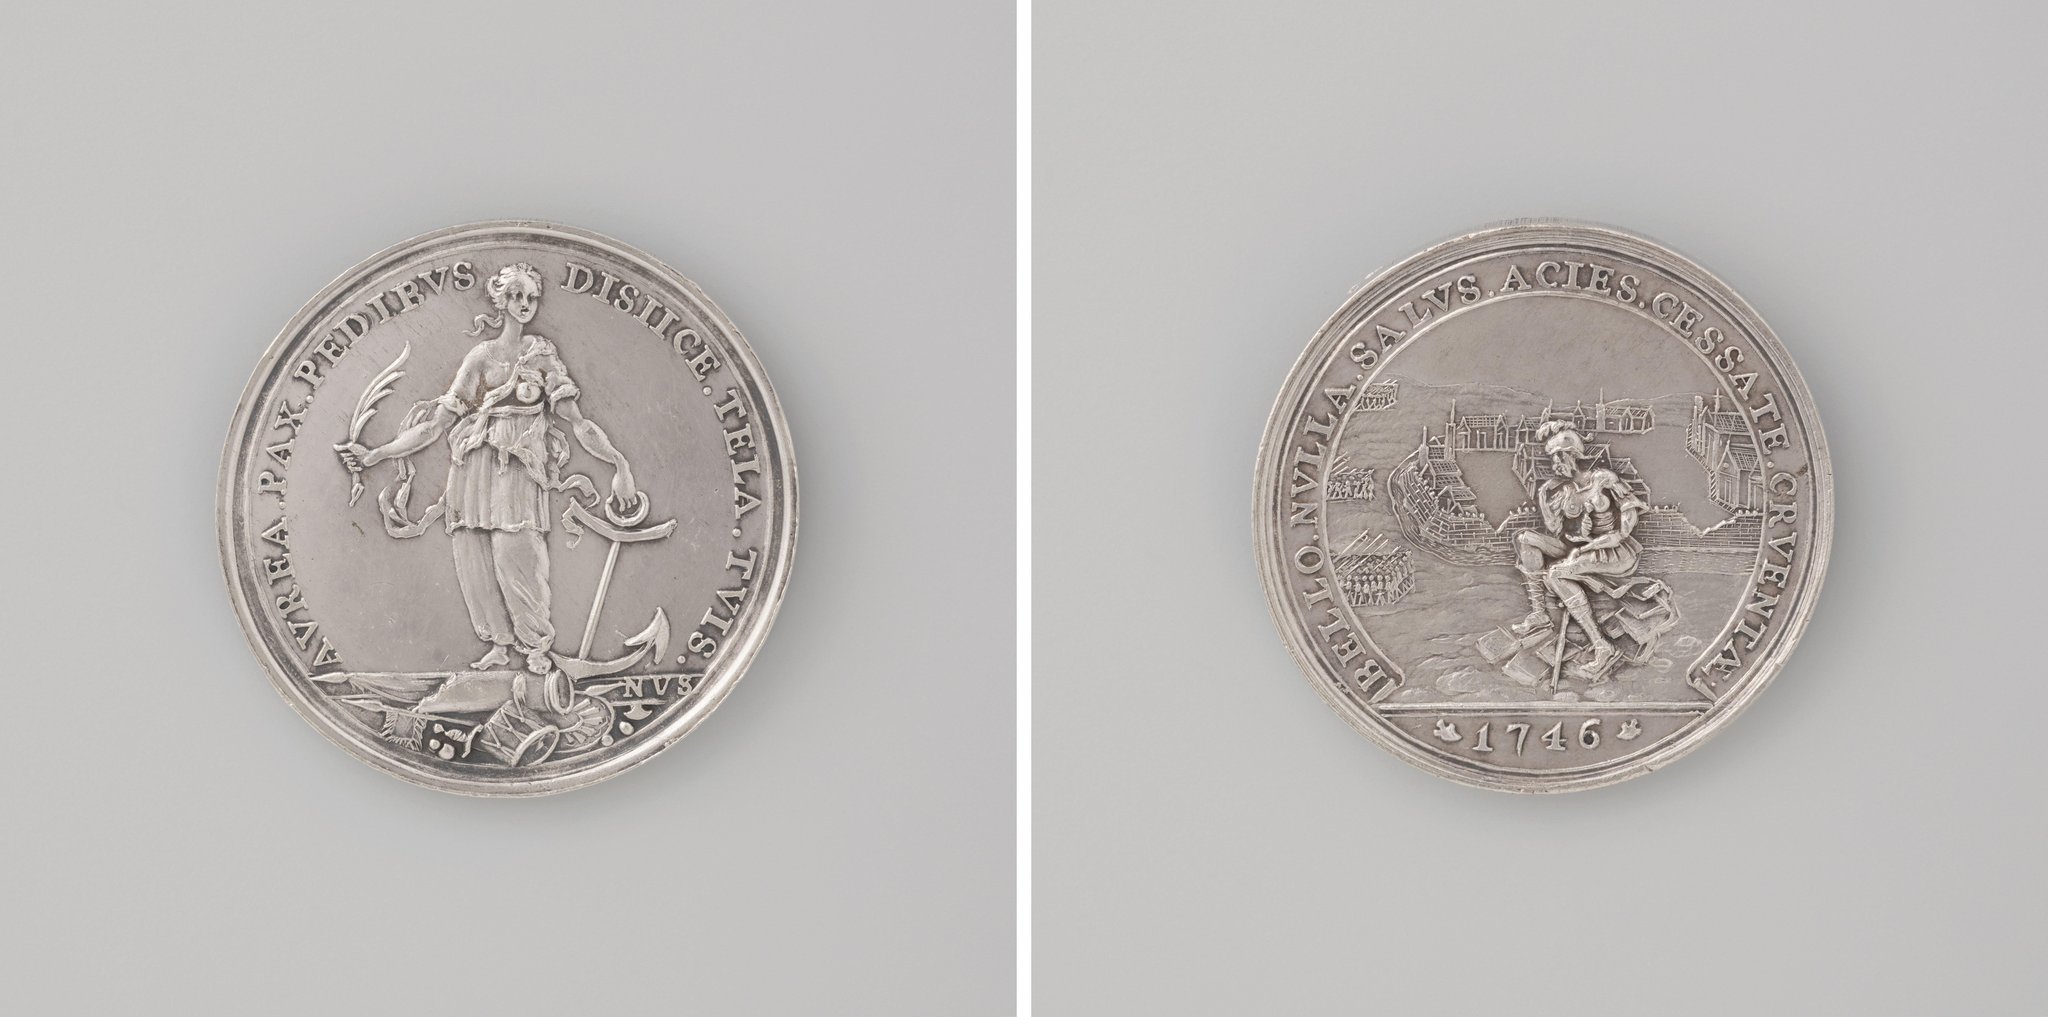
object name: new year medal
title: Aanvang van het jaar 1746, op de hoop op vrede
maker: nicolaas van swinderen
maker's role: jeweler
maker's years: 1705-1760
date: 1745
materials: silver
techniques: striking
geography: the hague